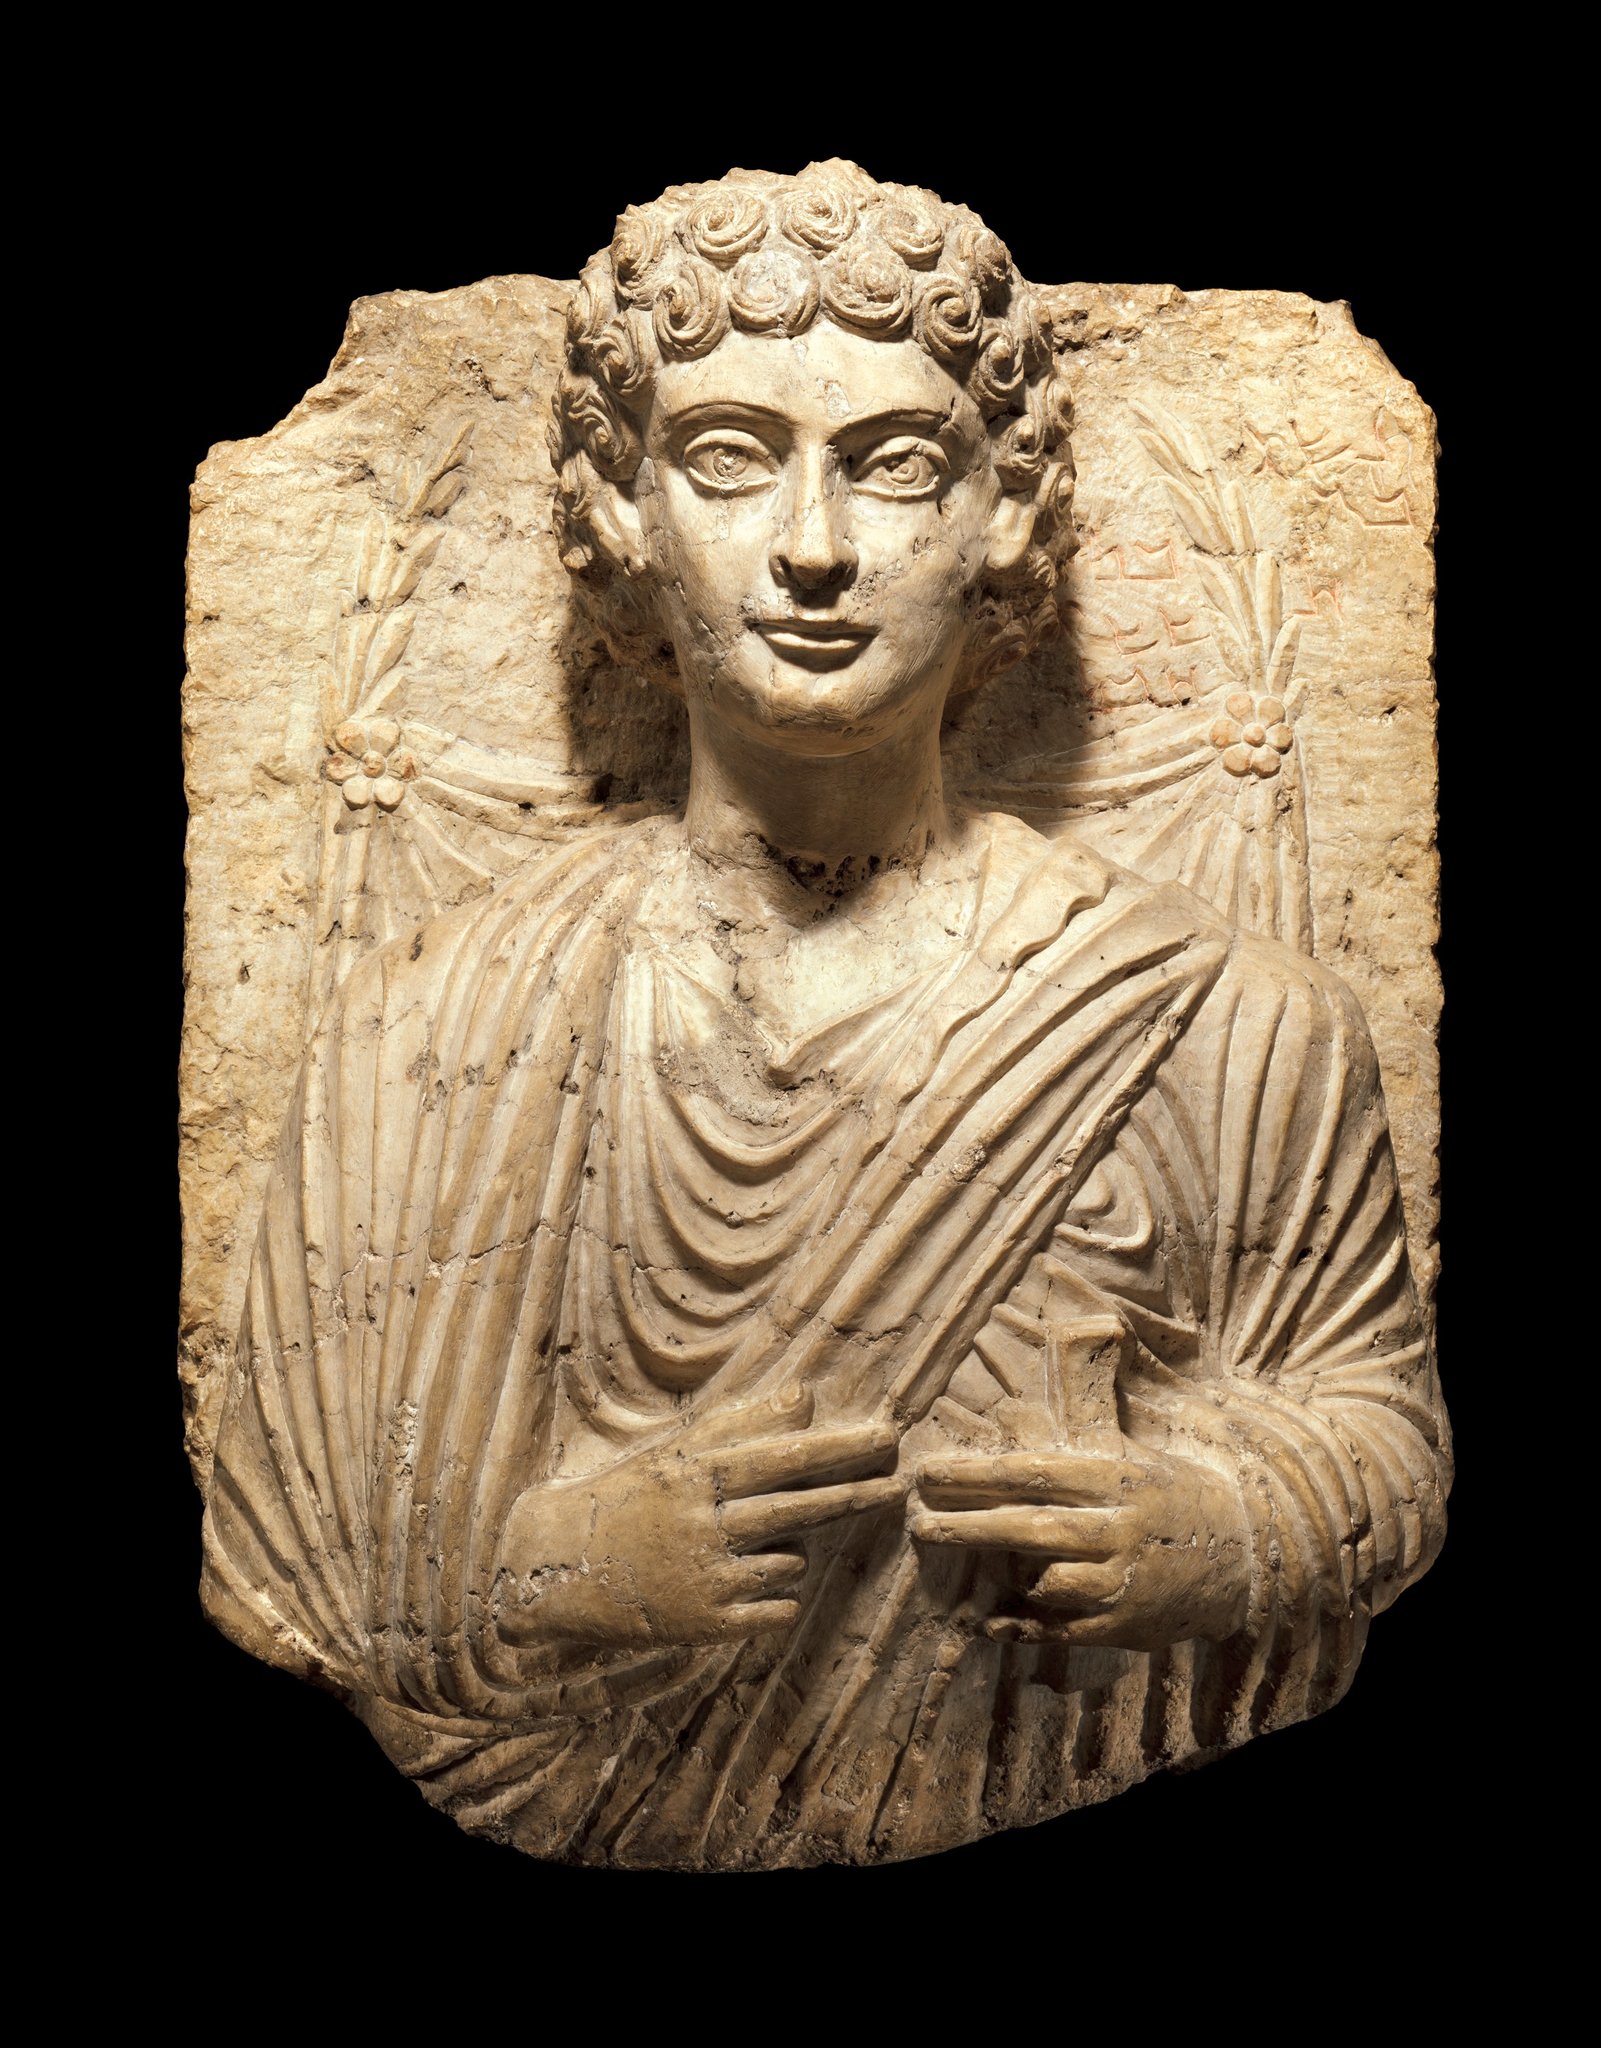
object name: funerary relief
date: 125-150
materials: limestone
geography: syria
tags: men